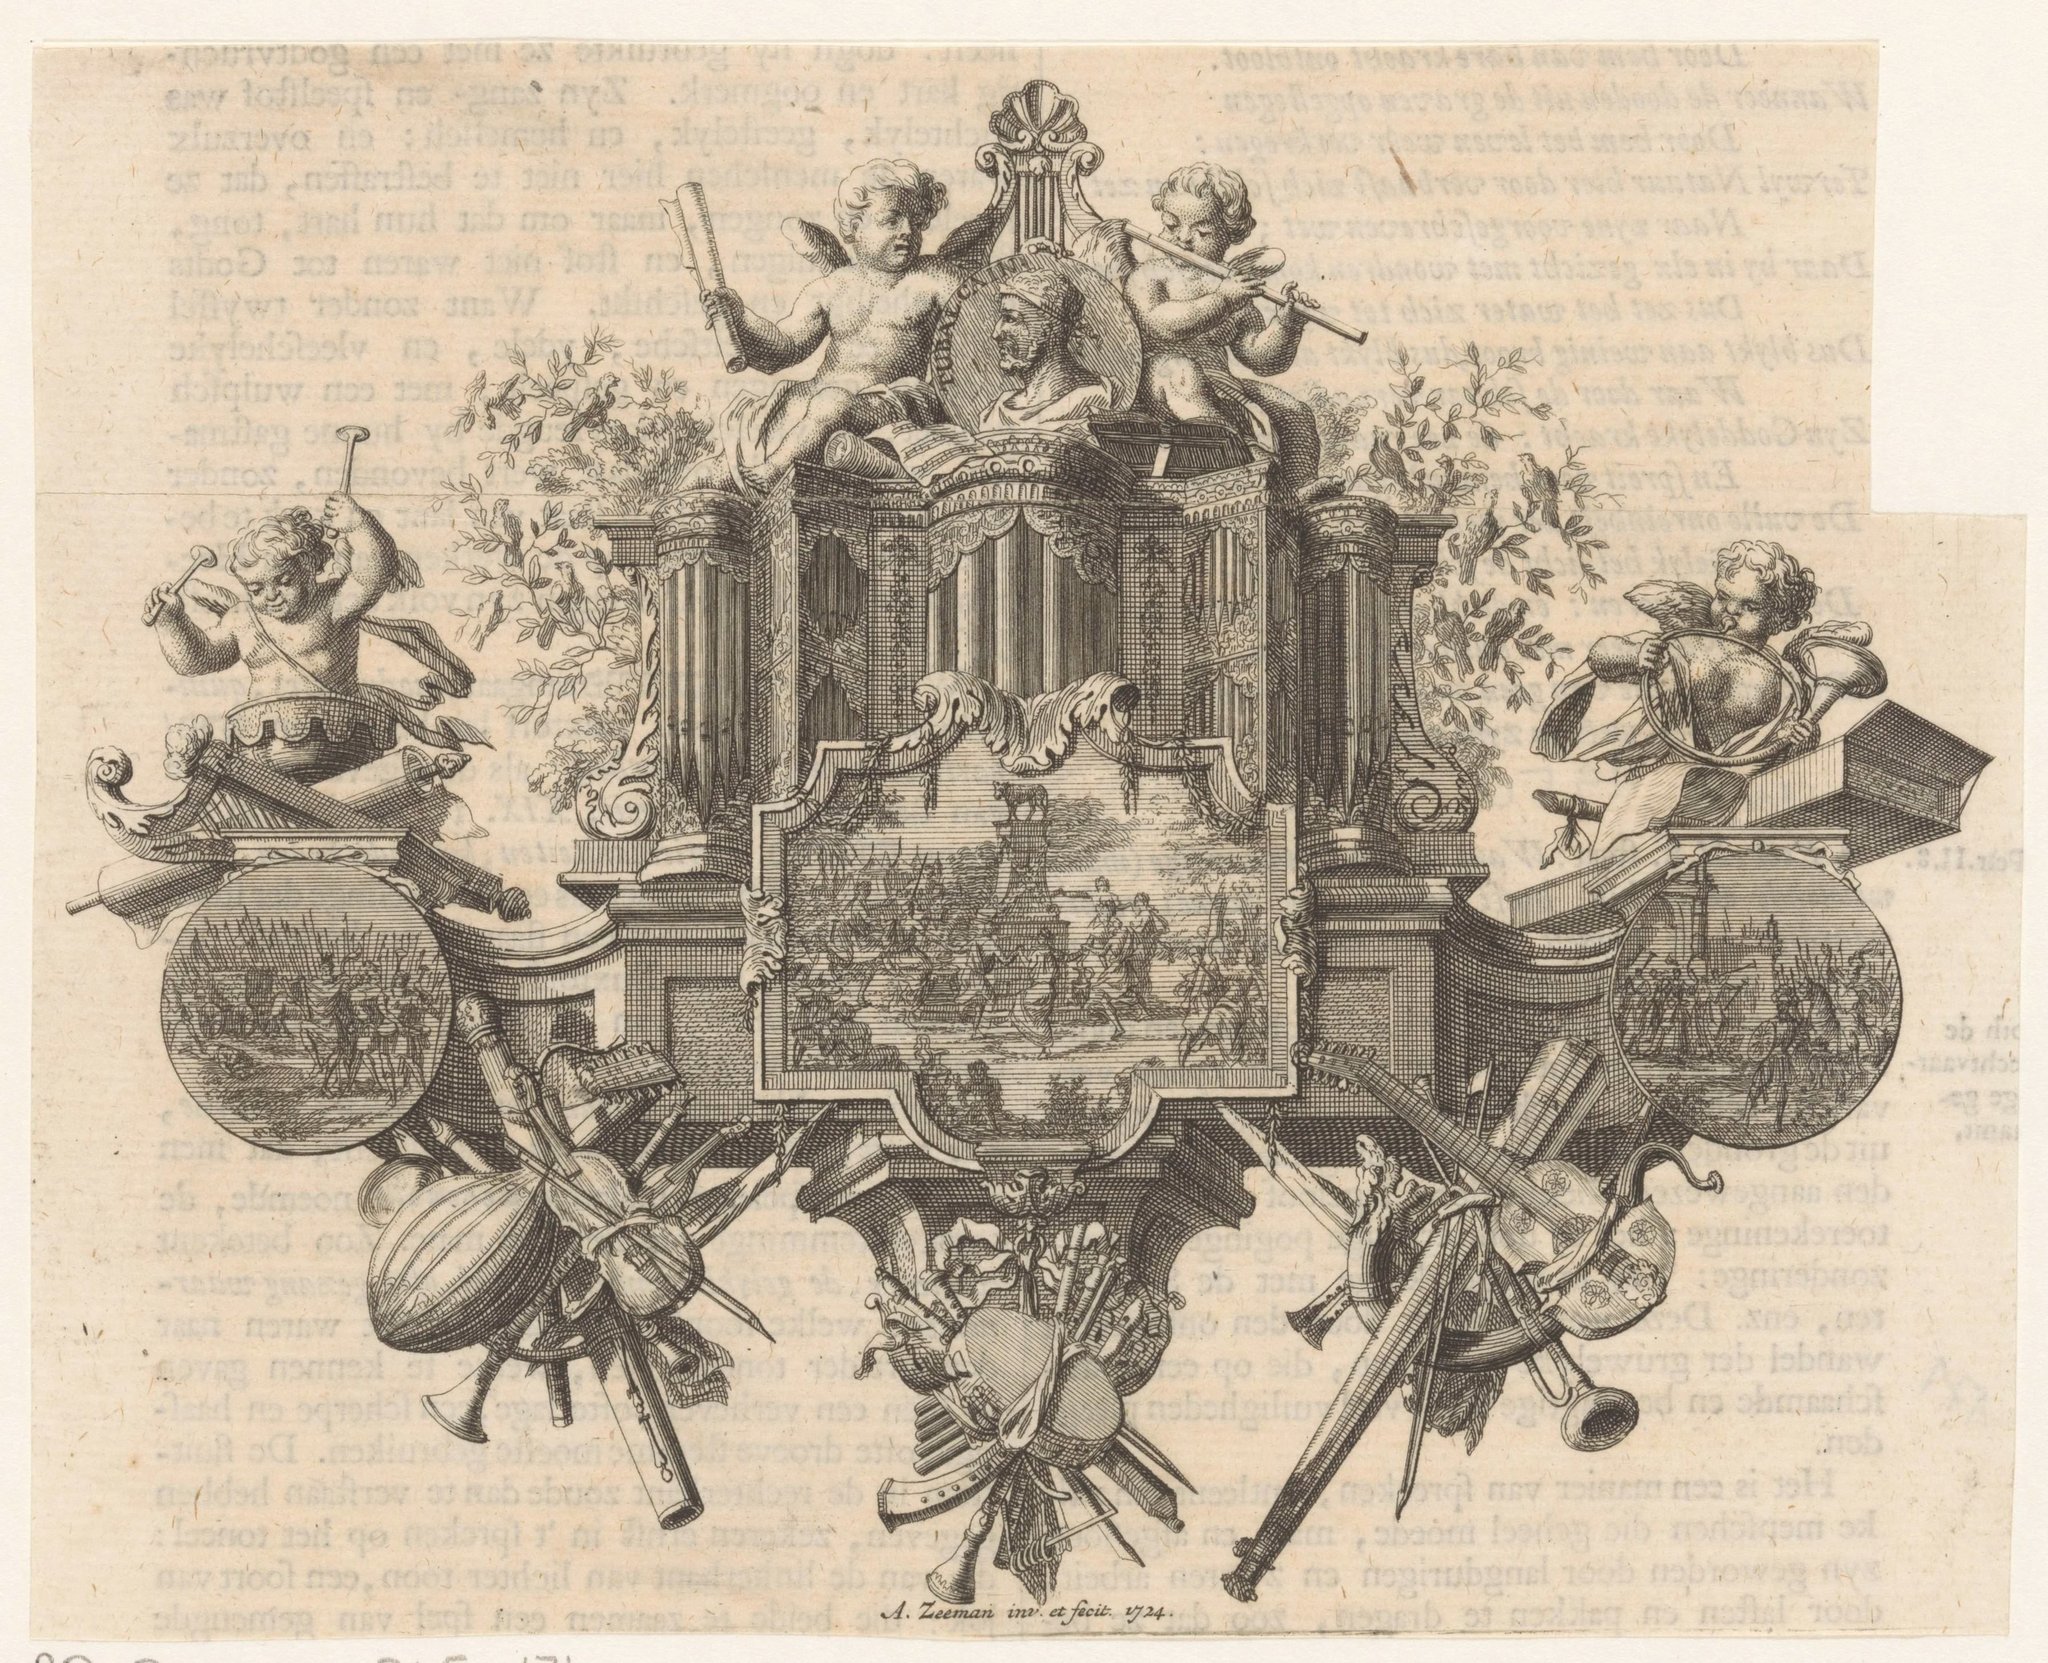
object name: print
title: Allegorische voorstelling over muziek rond het portret van Tubal-Kaïn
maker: abraham zeeman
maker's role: print maker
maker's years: 1695-1754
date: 1724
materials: paper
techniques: engraving, etching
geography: amsterdam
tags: story of tubalcain, the first blacksmith, 'musica', symbolic representations, allegories and emblems ~ music; 'musica'(ripa)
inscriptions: collector's mark: Lugt 2228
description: Orgel met midden boven een portret van Tubal-Kaïn, smid en stamvader van allen die brons en ijzer bewerken. (Volgens Gen. 4:22.) In het midden van het orgel een schilderij van de dans om het gouden kalf. Op het orgel putti met muziekinstrumenten, die van metaal gemaakt zijn, en onderaan drie trofeeën van muziekinstrumenten.